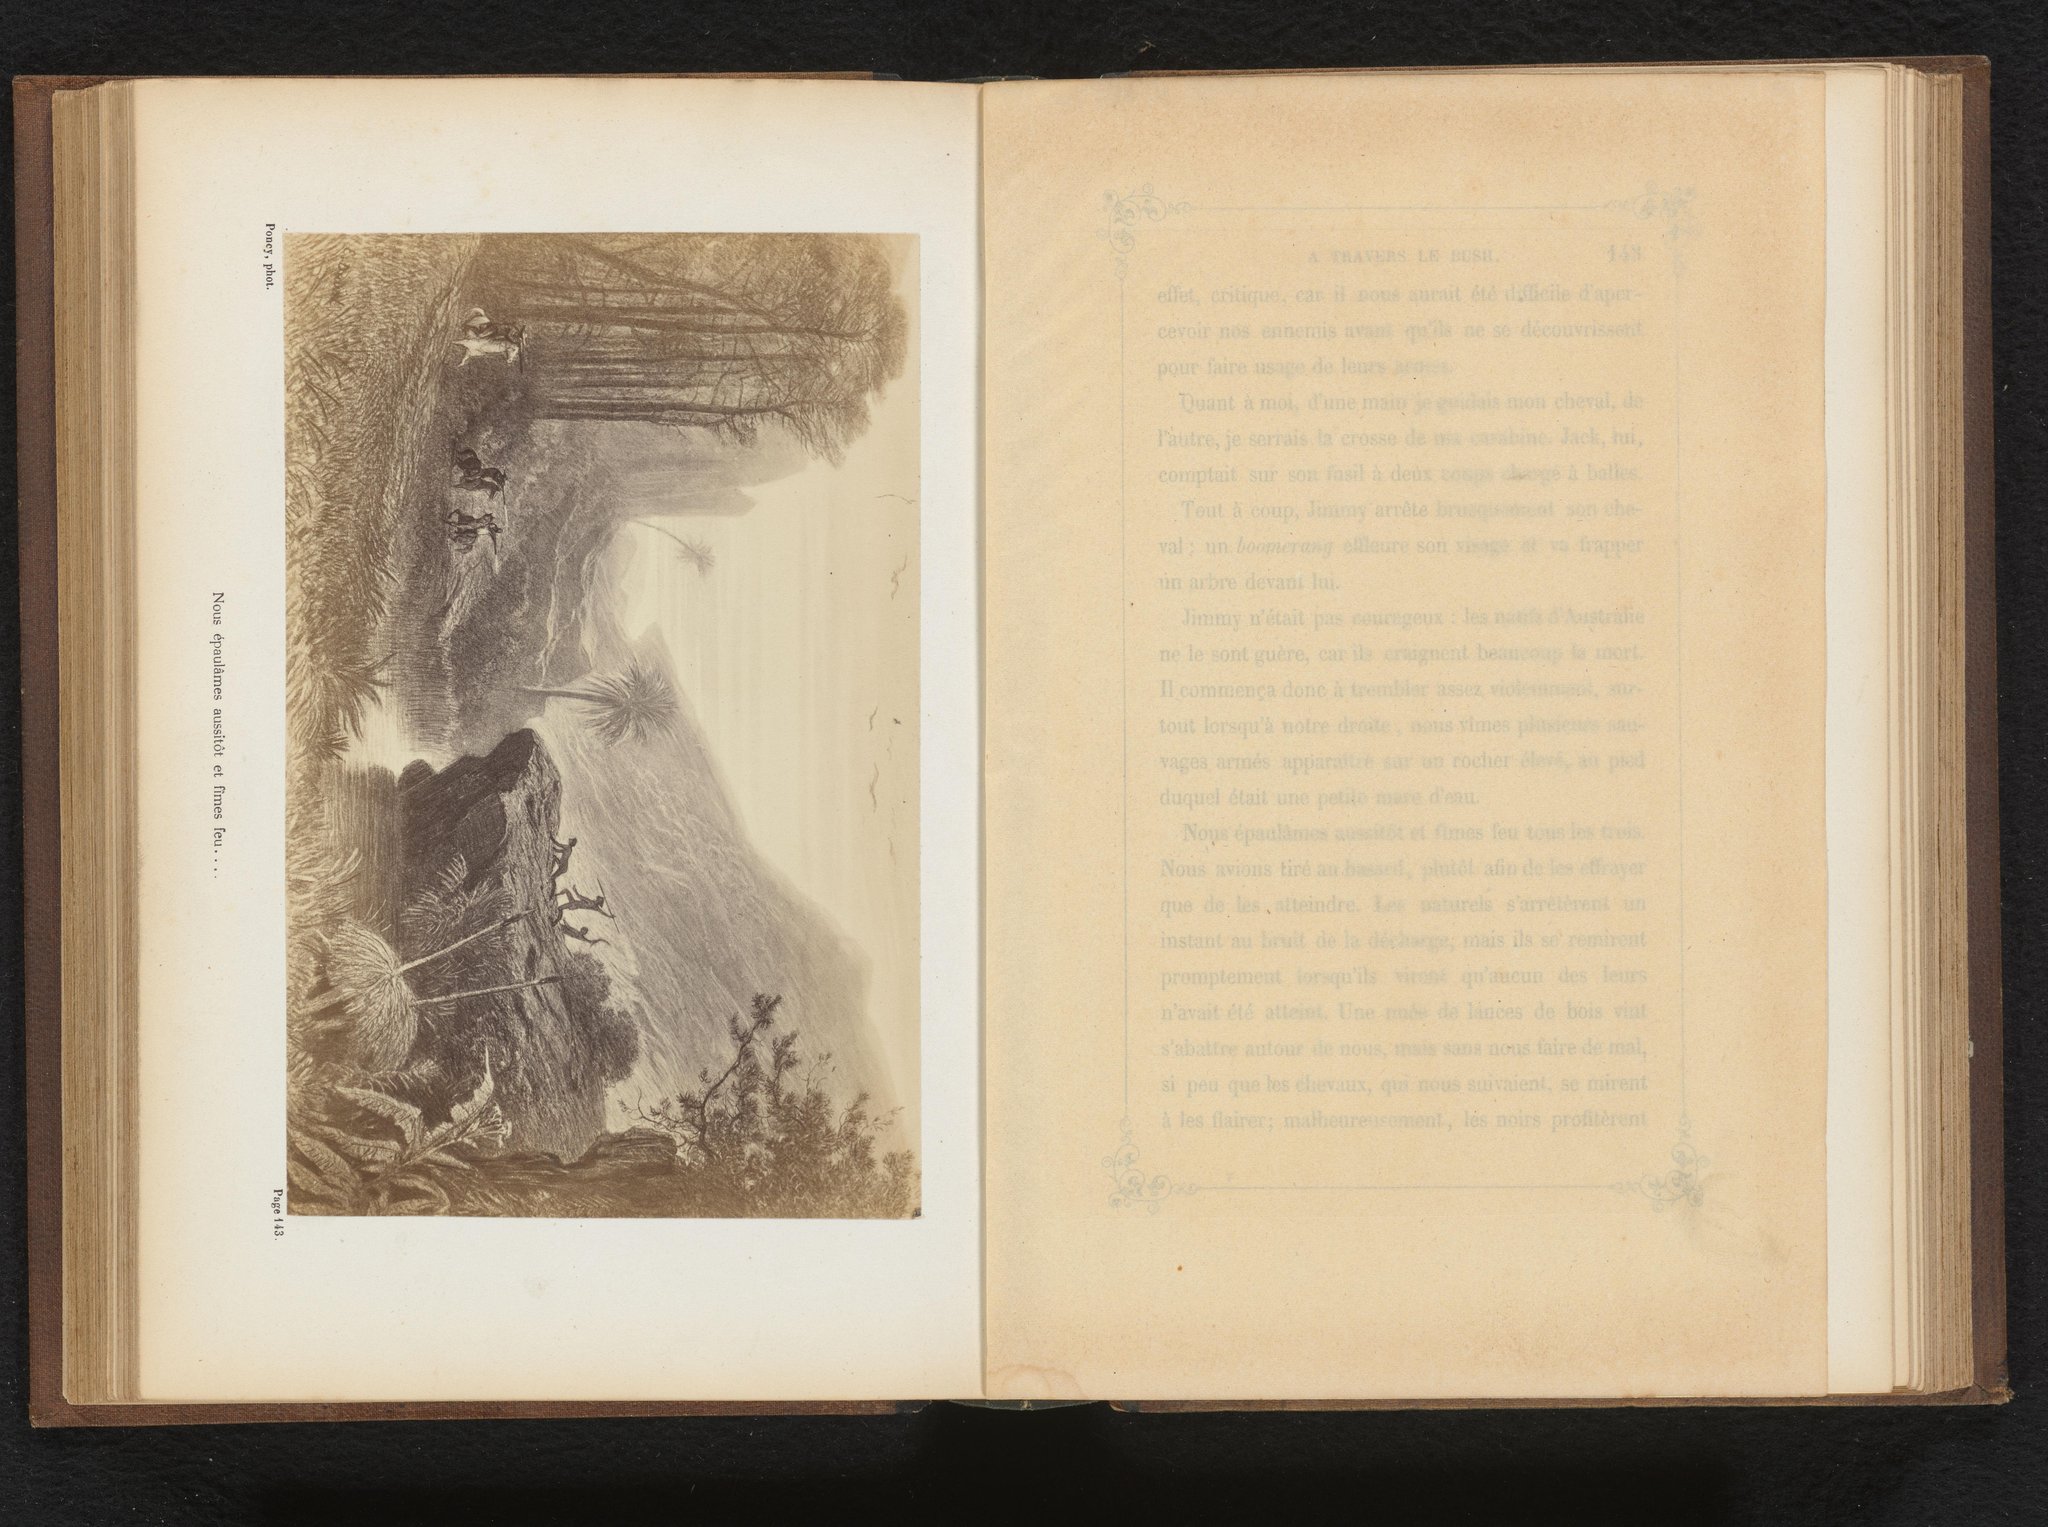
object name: photograph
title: Nous épaulâmes aussitôt et fimes feu...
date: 1863-1868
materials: paper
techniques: albumen print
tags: imperialism, australian and oceanian races, australia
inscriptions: inscription: ‘Page 143.’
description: Foto op ongenummerde pagina voor pagina 143.